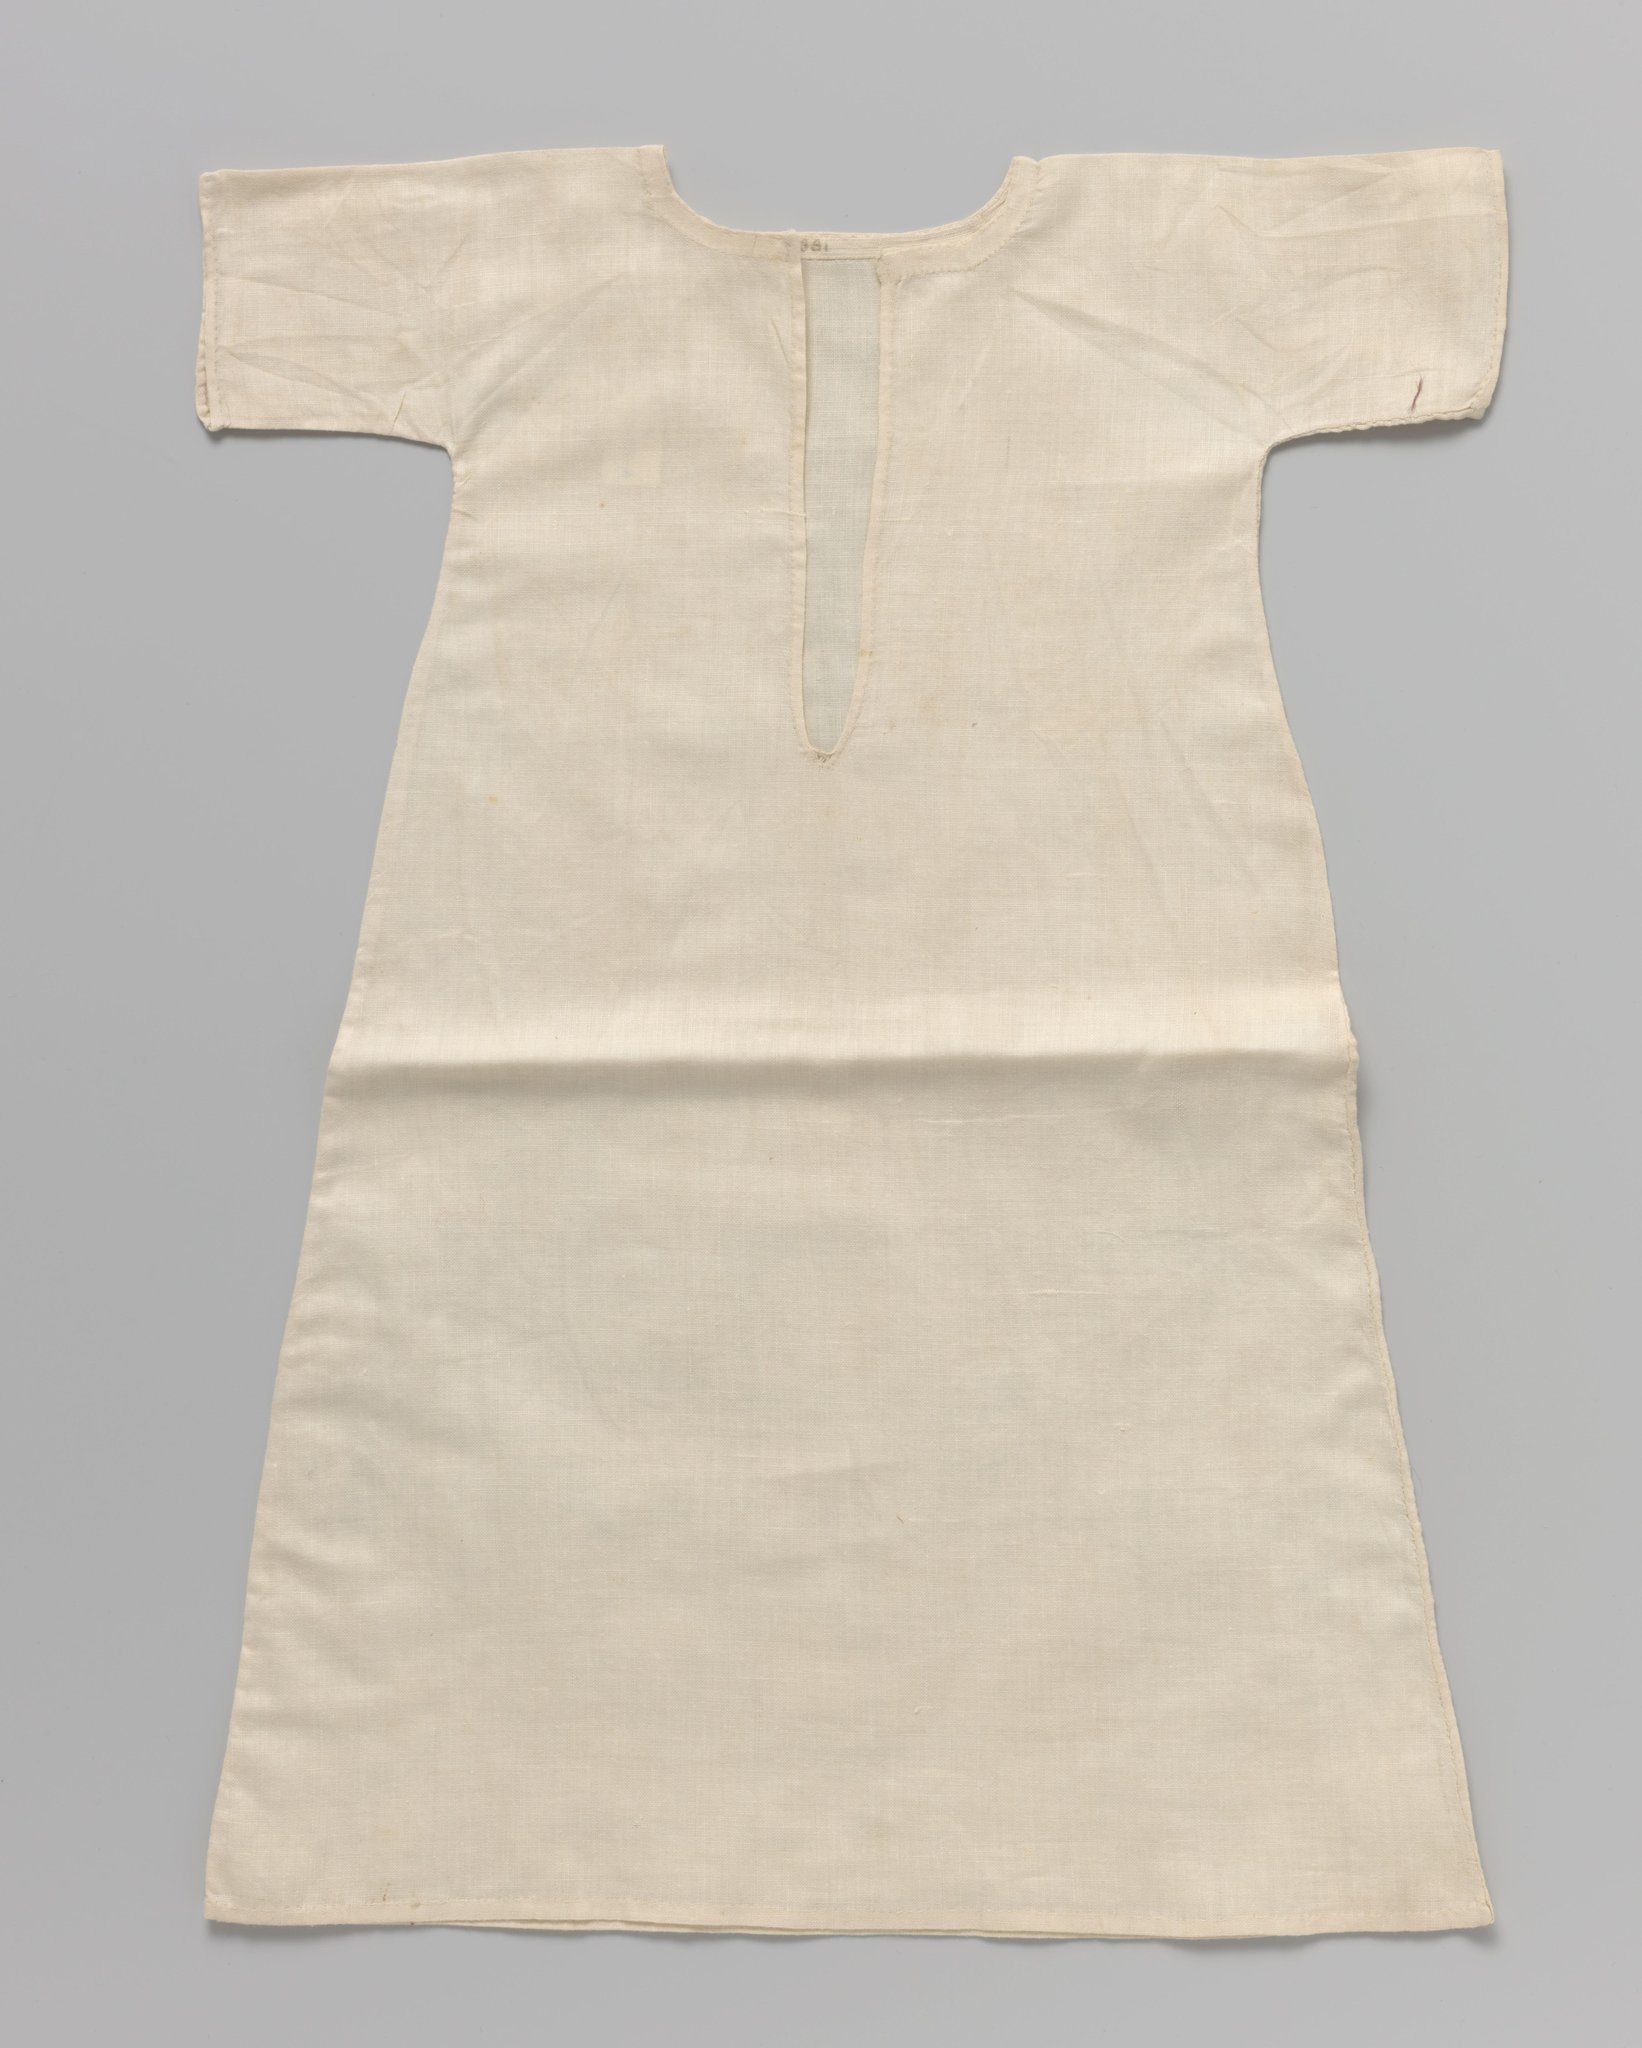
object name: streekdracht, streekkleding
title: Hemd of mouwhemd van linnen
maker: Anonymous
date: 1850-1900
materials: linen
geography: netherlands